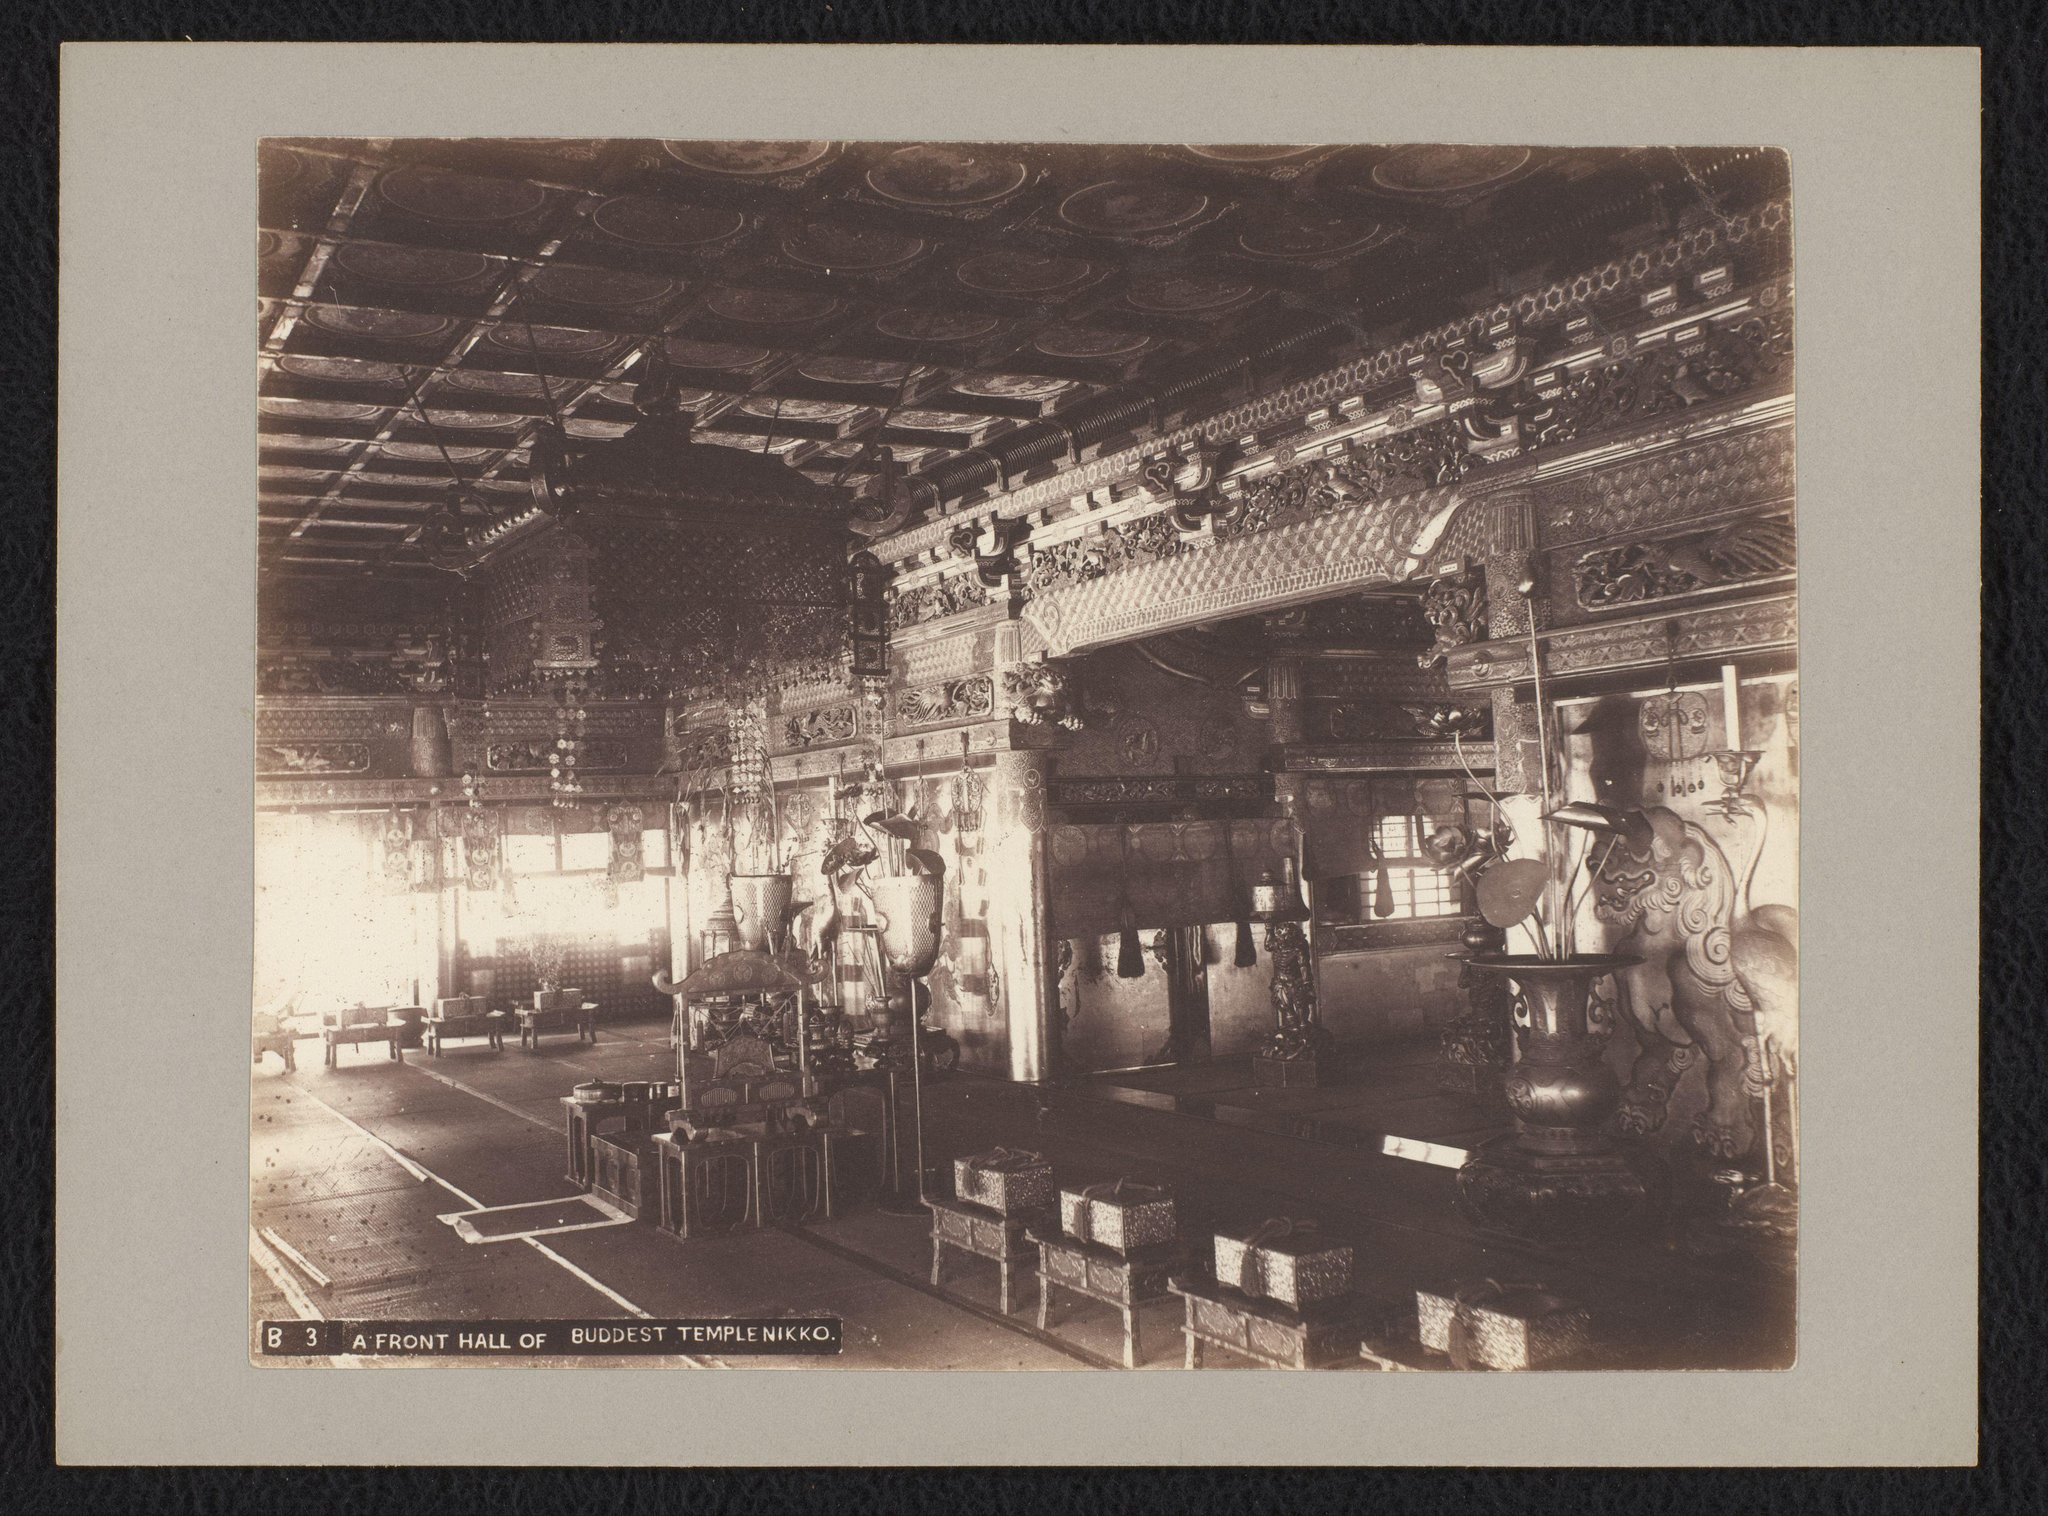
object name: photograph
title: B 3 A front hall of Buddest Temple Nikko.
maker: Anonymous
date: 1895-1915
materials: cardboard, photographic support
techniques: salted paper print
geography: nikko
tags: nikko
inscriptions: number: ‘3.3.’